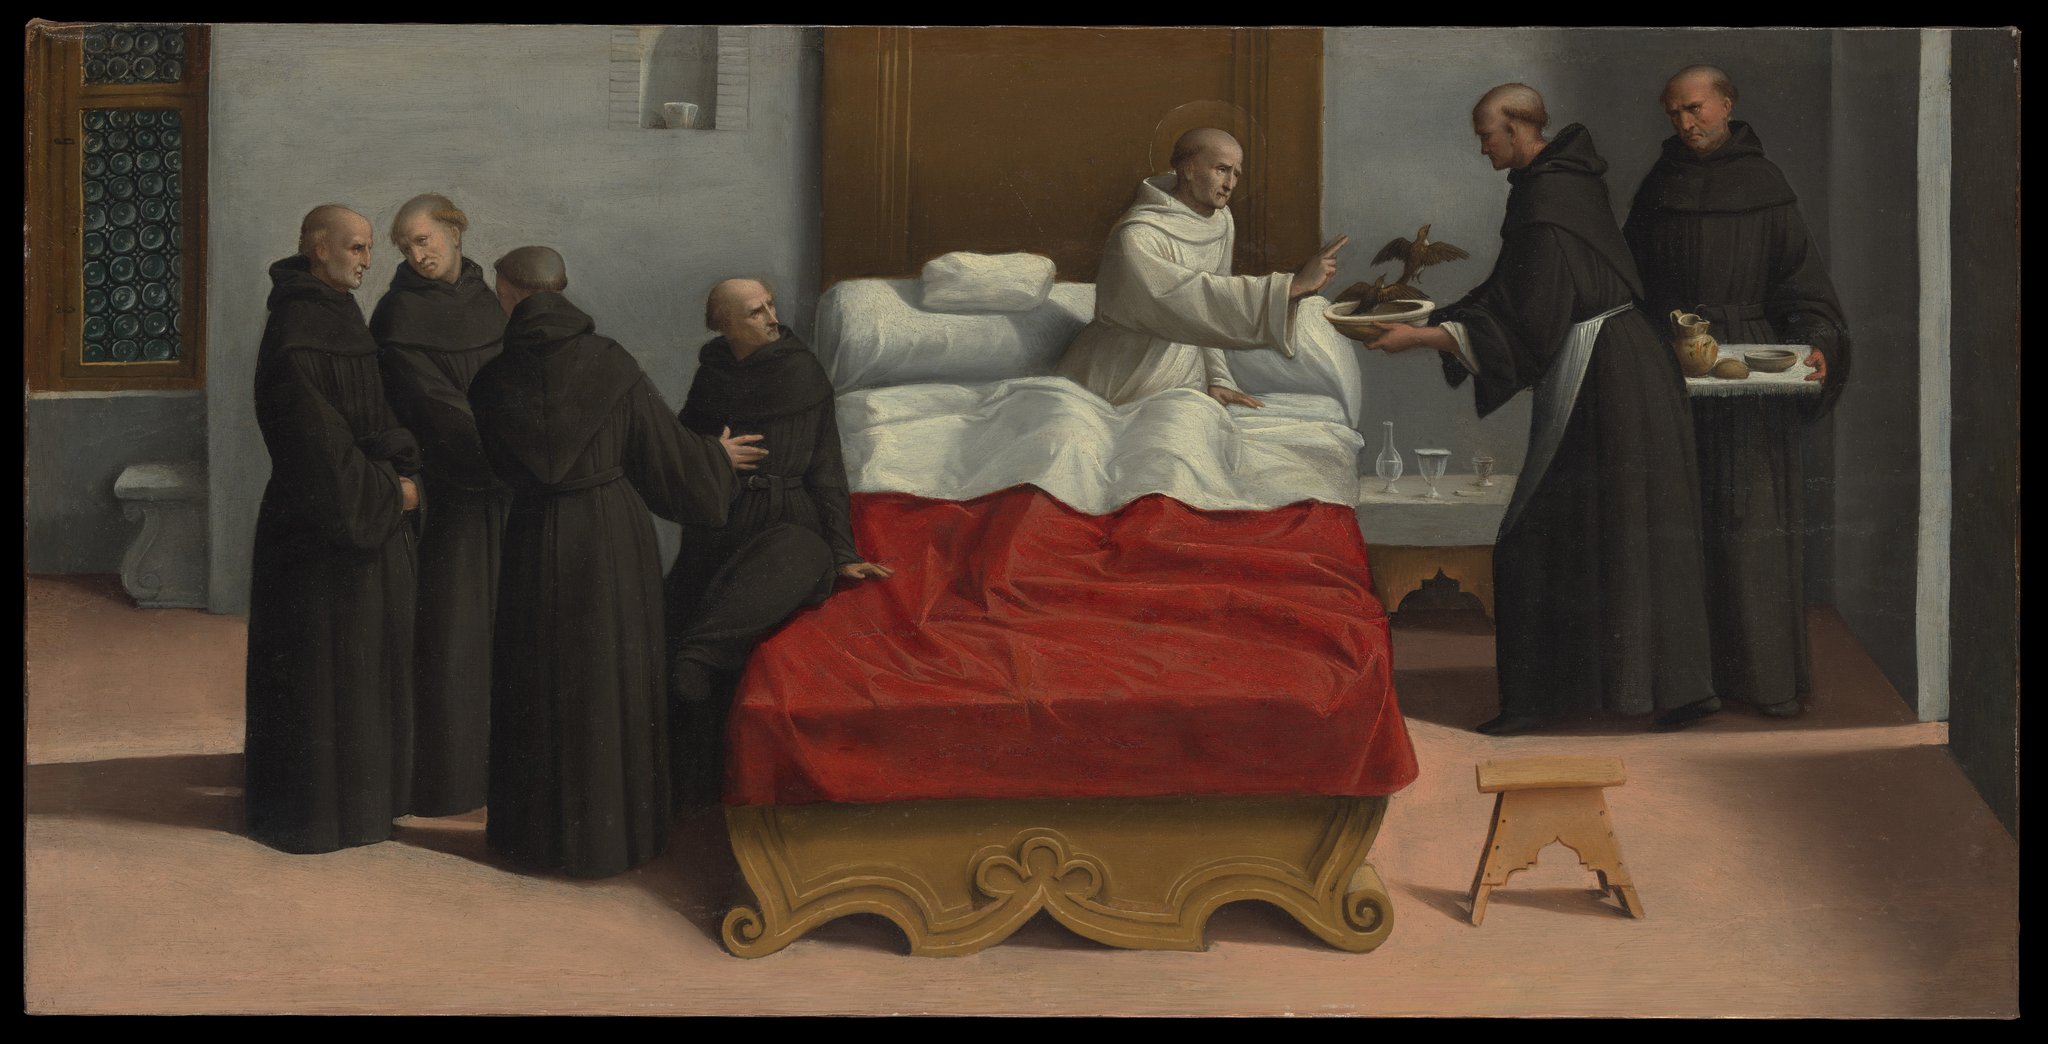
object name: painting, predella panel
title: Saint Nicholas of Tolentino Reviving the Birds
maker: garofalo (benvenuto tisi da garofalo)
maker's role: artist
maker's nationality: italian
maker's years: 1481-1559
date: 1530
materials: canvas, oil, wood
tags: birds,bedrooms,men,monks,saints,beds